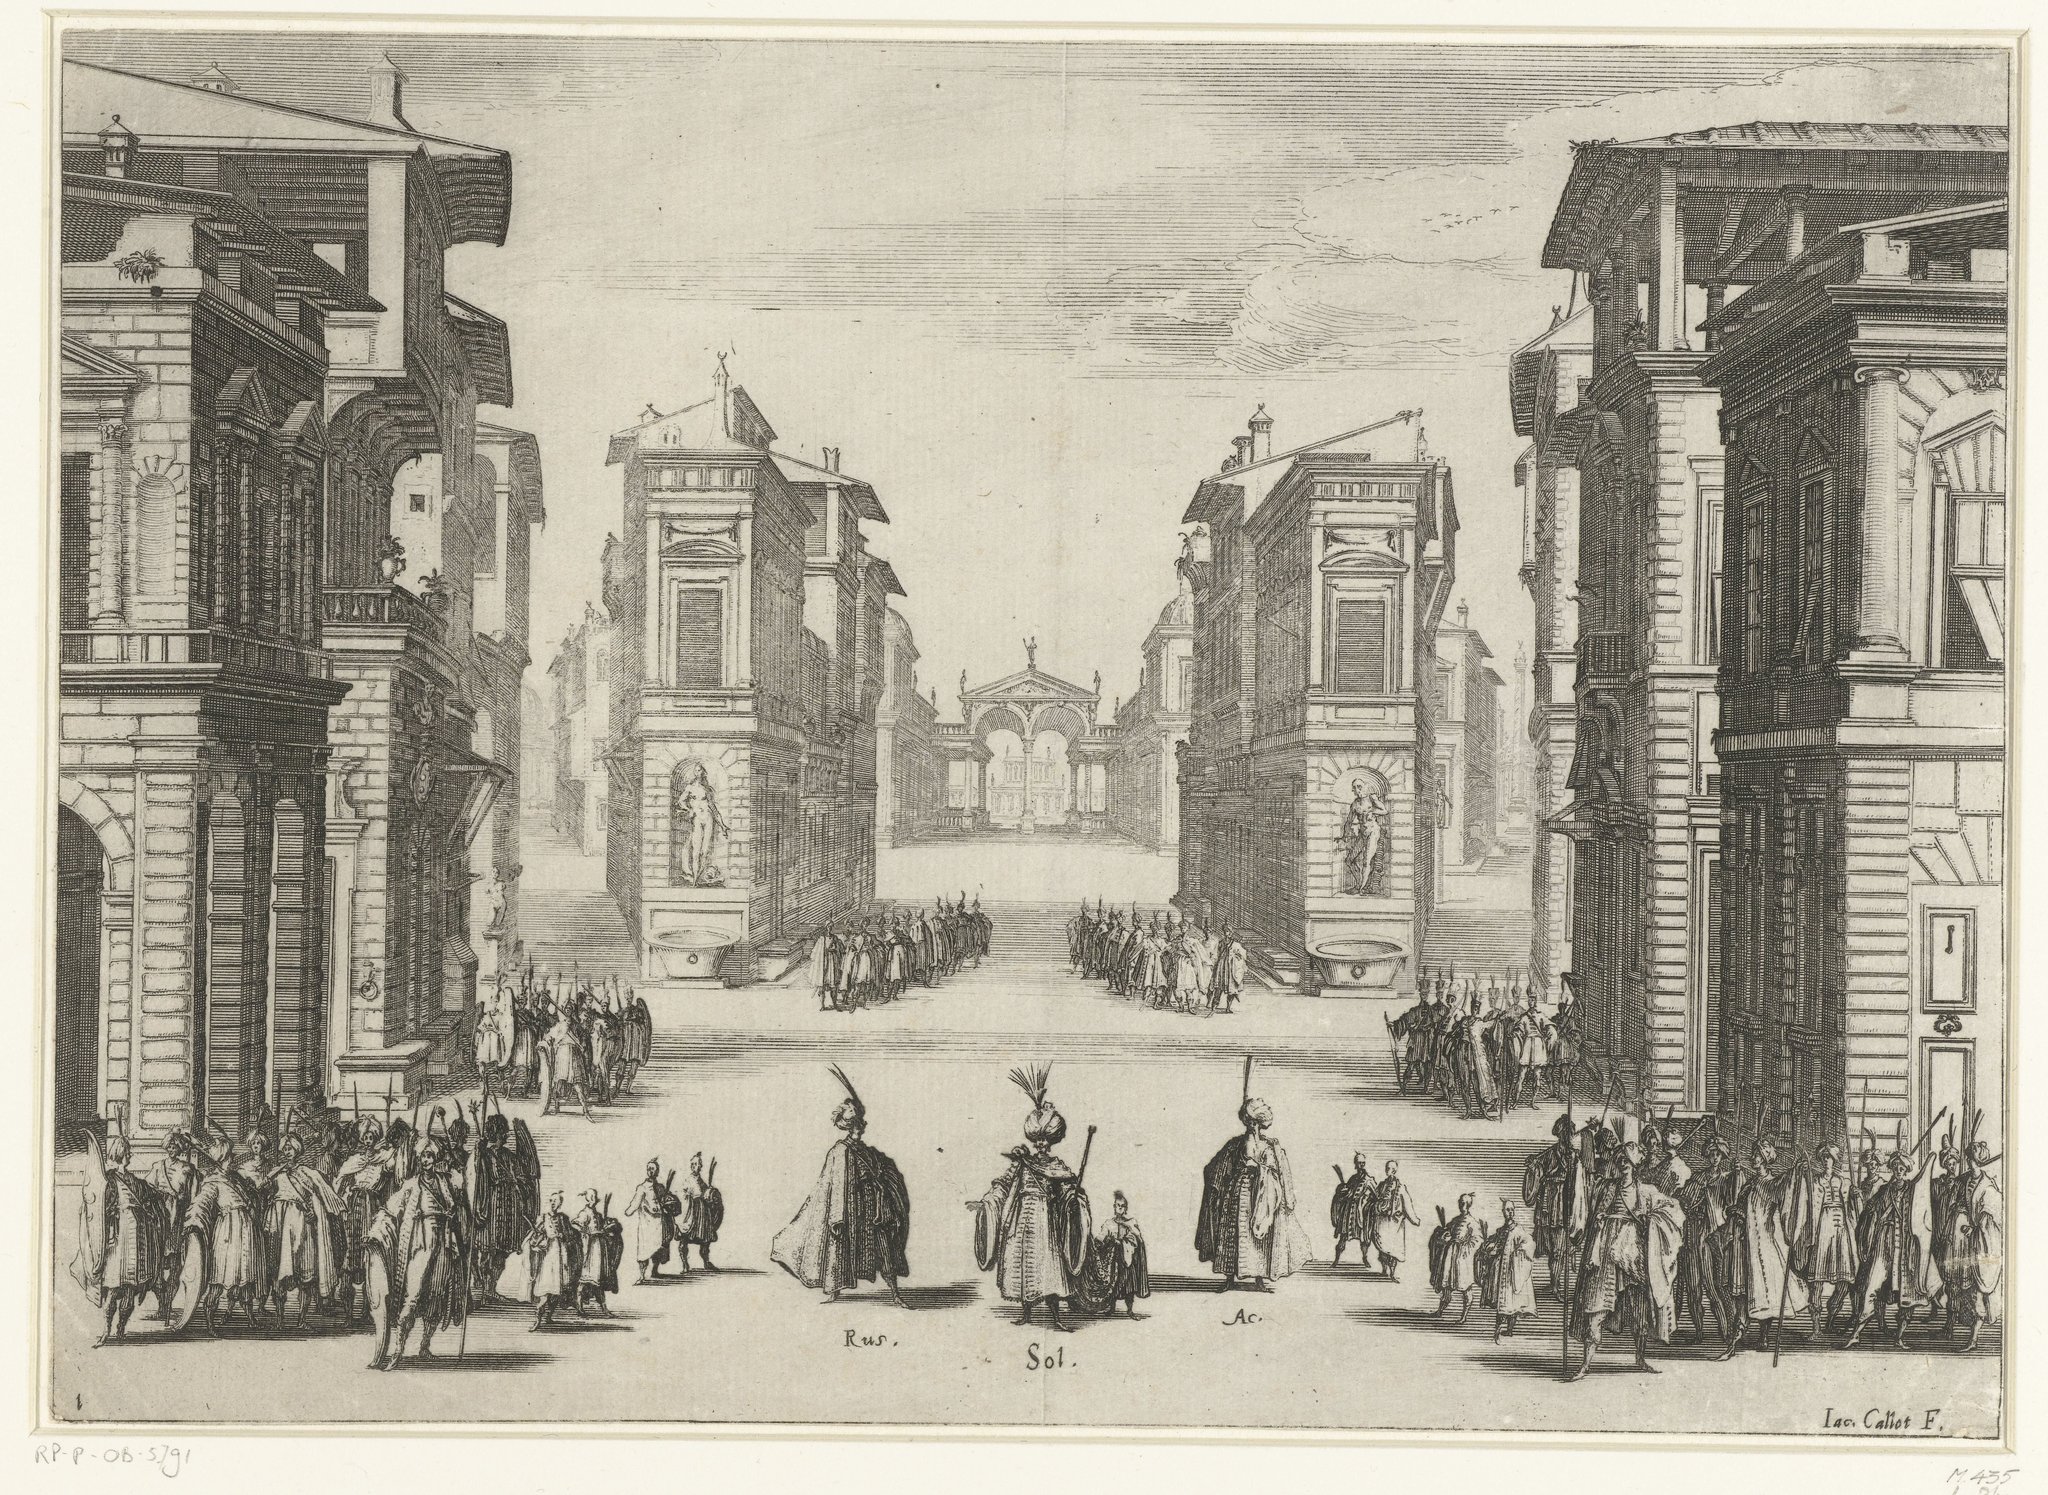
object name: print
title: Illustratie bij de eerste acte van de tragedie 'Il Solimano'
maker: jacques callot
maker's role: draughtsman, print maker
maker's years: 1592-1635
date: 1619-1620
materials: paper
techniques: engraving, etching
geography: florence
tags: asiatic races and peoples: turks, street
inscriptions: collector's mark: Lugt 240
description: Op een plein of brede straat met grote gebouwen staan drie oosters geklede figuren met korte aanduidingen van hun namen bij hun voeten (personages in de tragedie 'Il Solimano'), omgeven door vele overige acteurs, opgesteld in vier blokken en twee rijen.